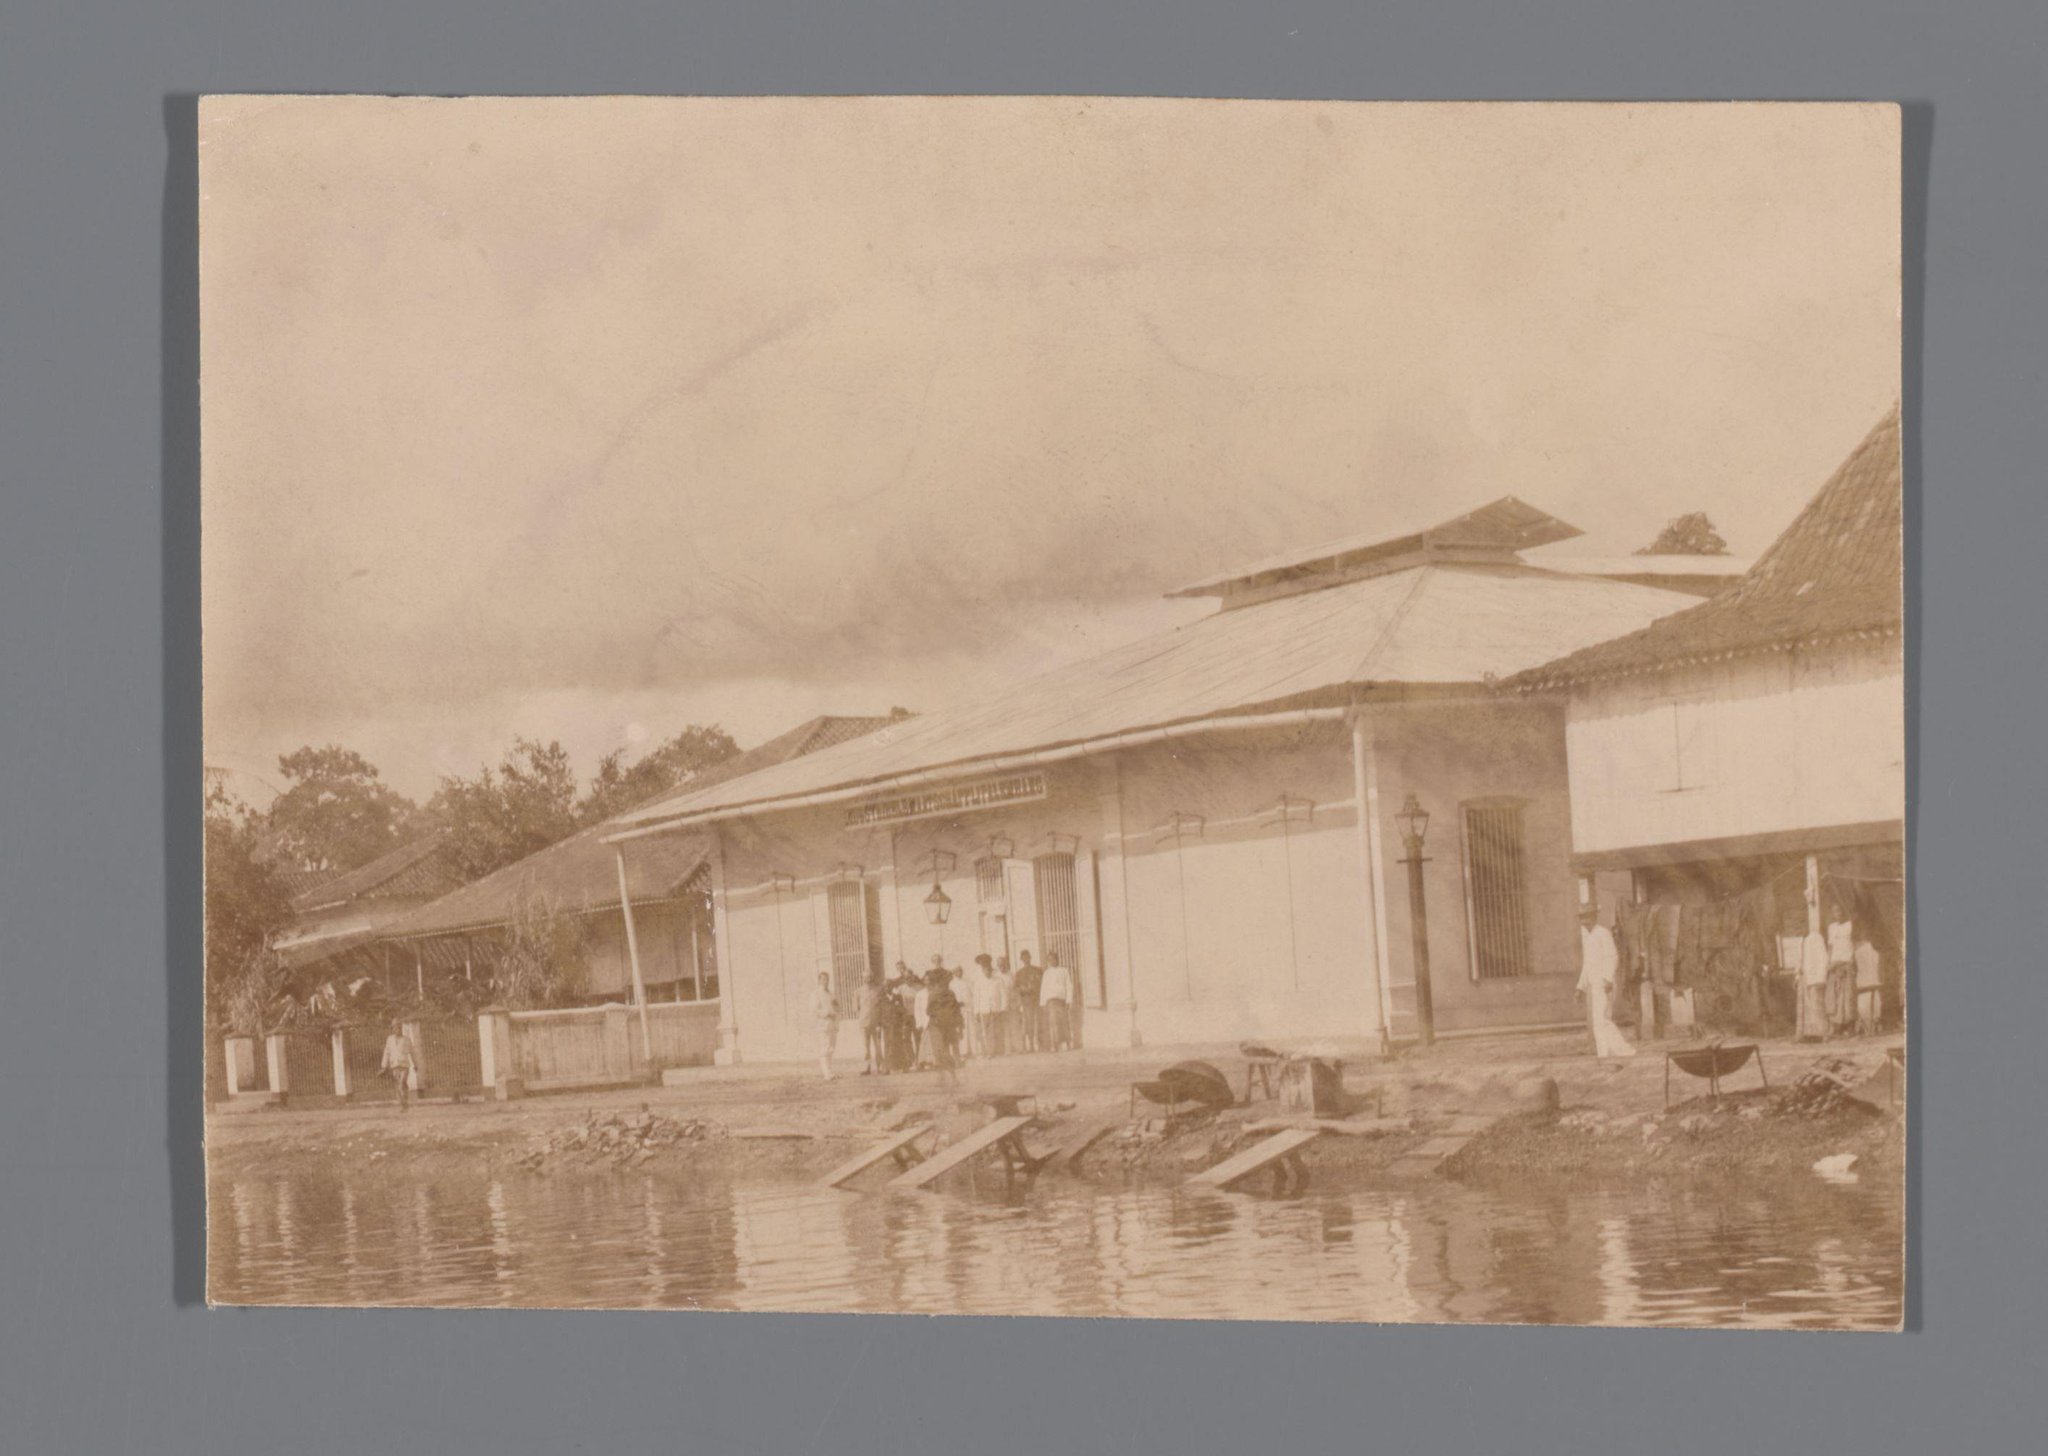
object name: photograph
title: Industrieele Maatschappij te Palembang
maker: Anonymous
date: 1900-1910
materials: photographic support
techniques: collodion silver print, gelatin silver print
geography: palembang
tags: palembang (city), dutch east indies, the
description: Gezicht op het gebouw van de Industrieele Maatschappij te Palembang, werknemers poseren bij de ingang, ca. 1900-1910. Onderdeel van een groep van 14 losse foto's genomen op Midden- en Zuid-Sumatra in de periode ca. 1900-1940.